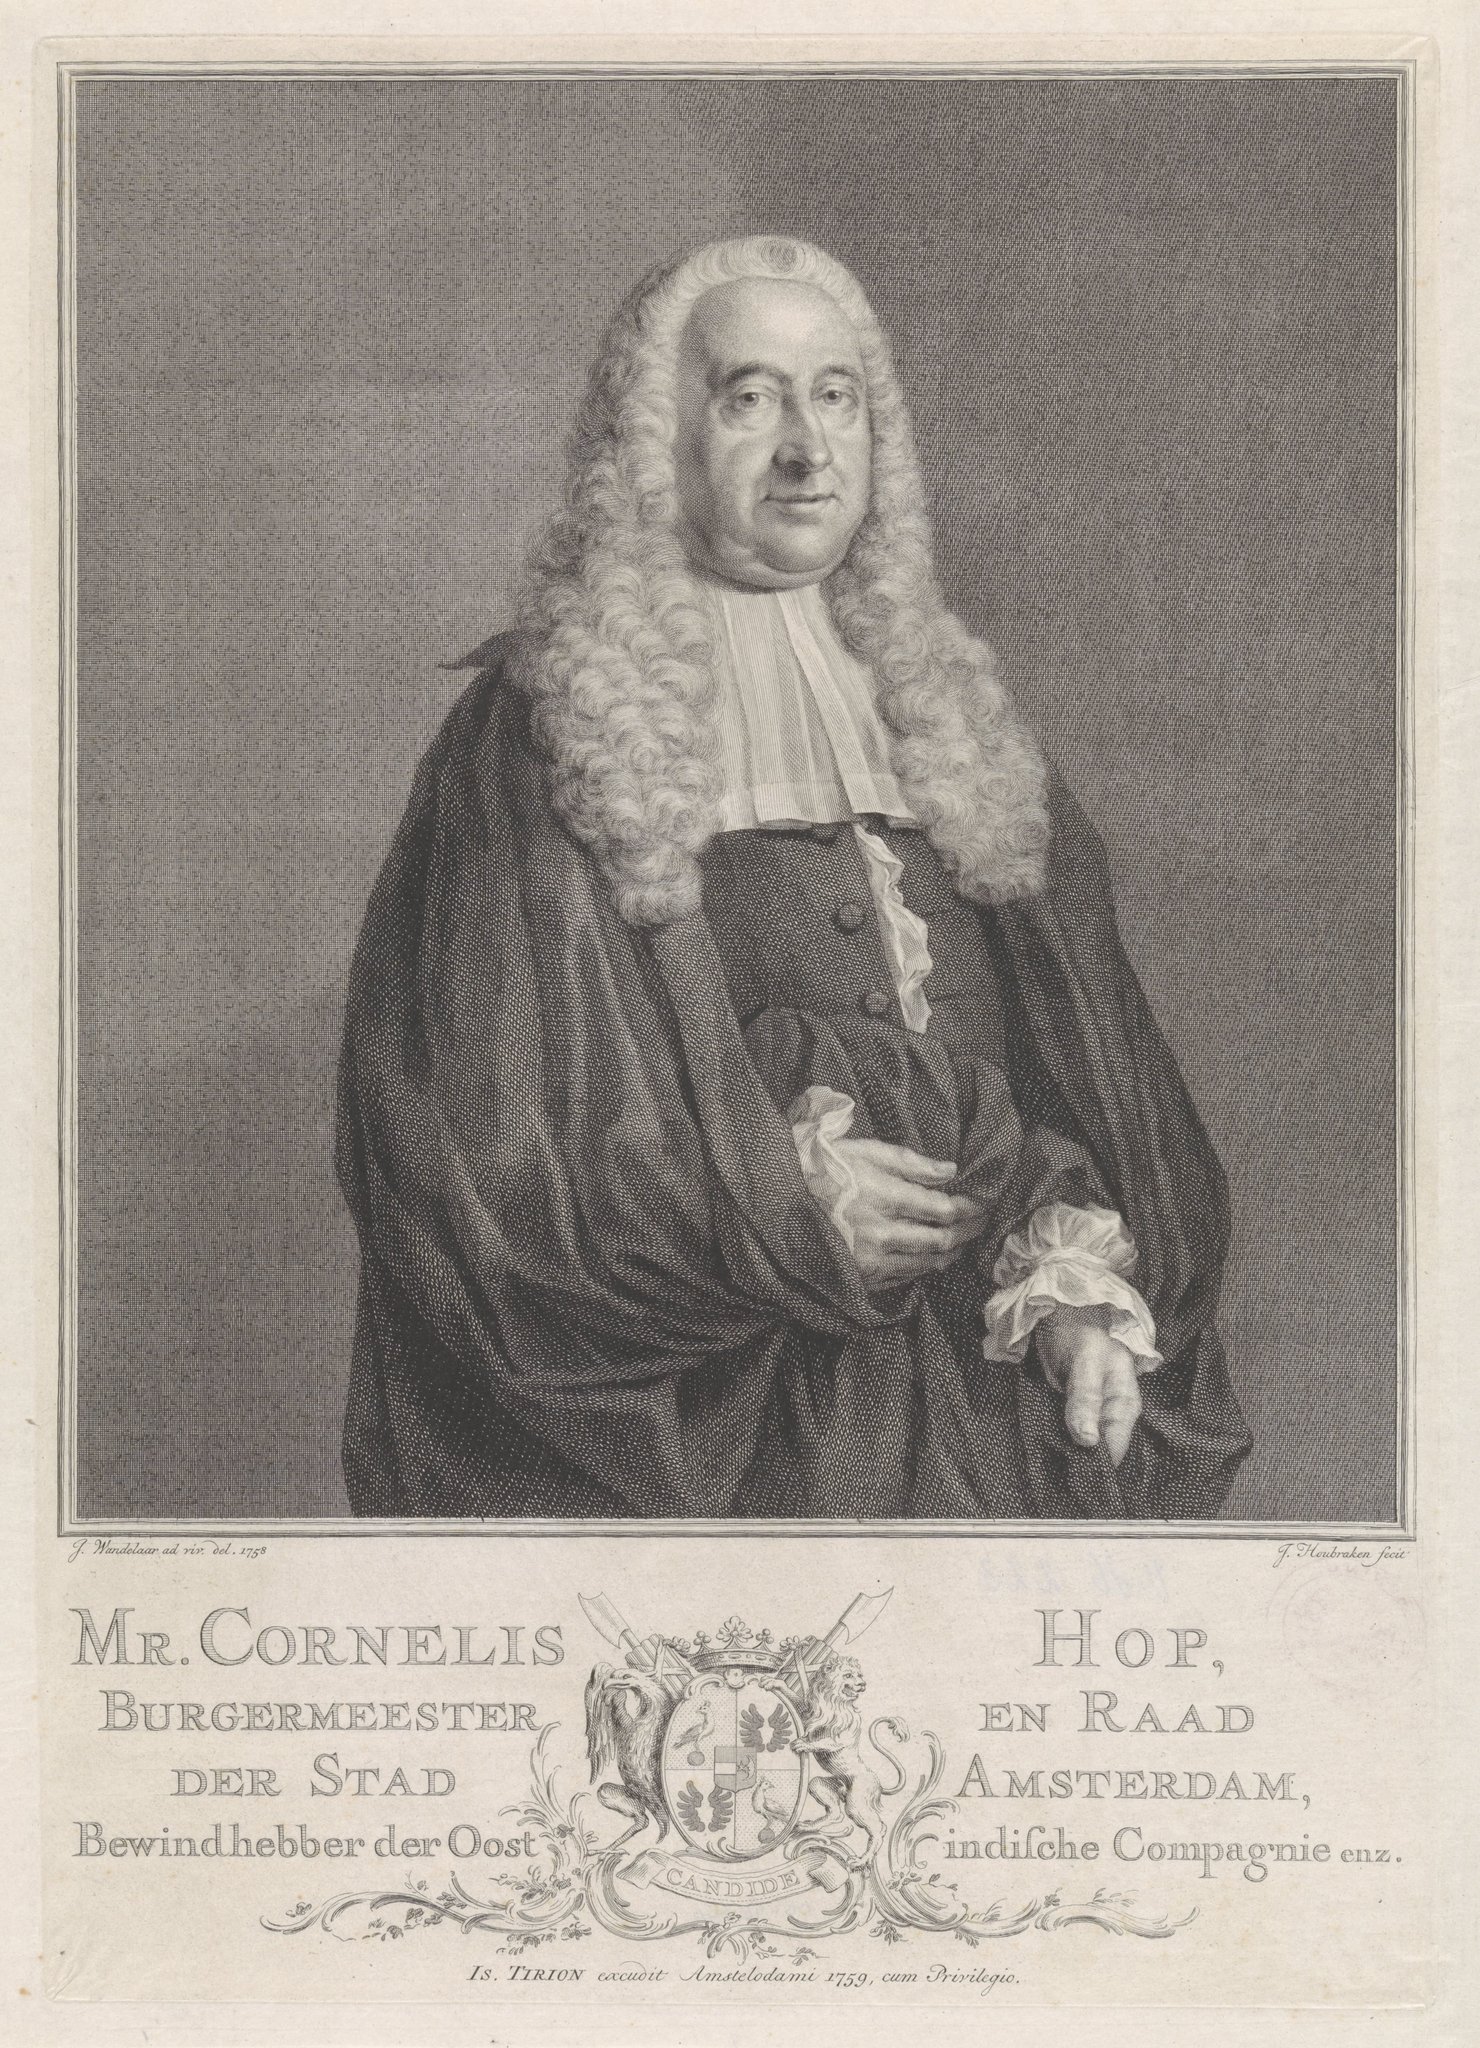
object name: print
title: Portret van Cornelis Hop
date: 1759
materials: paper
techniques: engraving, etching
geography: amsterdam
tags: cornelis hop (ii)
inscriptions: collector's mark: Lugt 240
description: Portret ten halven lijve naar rechts van Cornelis Hop. Onder het portret zijn wapen en zijn naam en gegevens in vier regels in het Nederlands